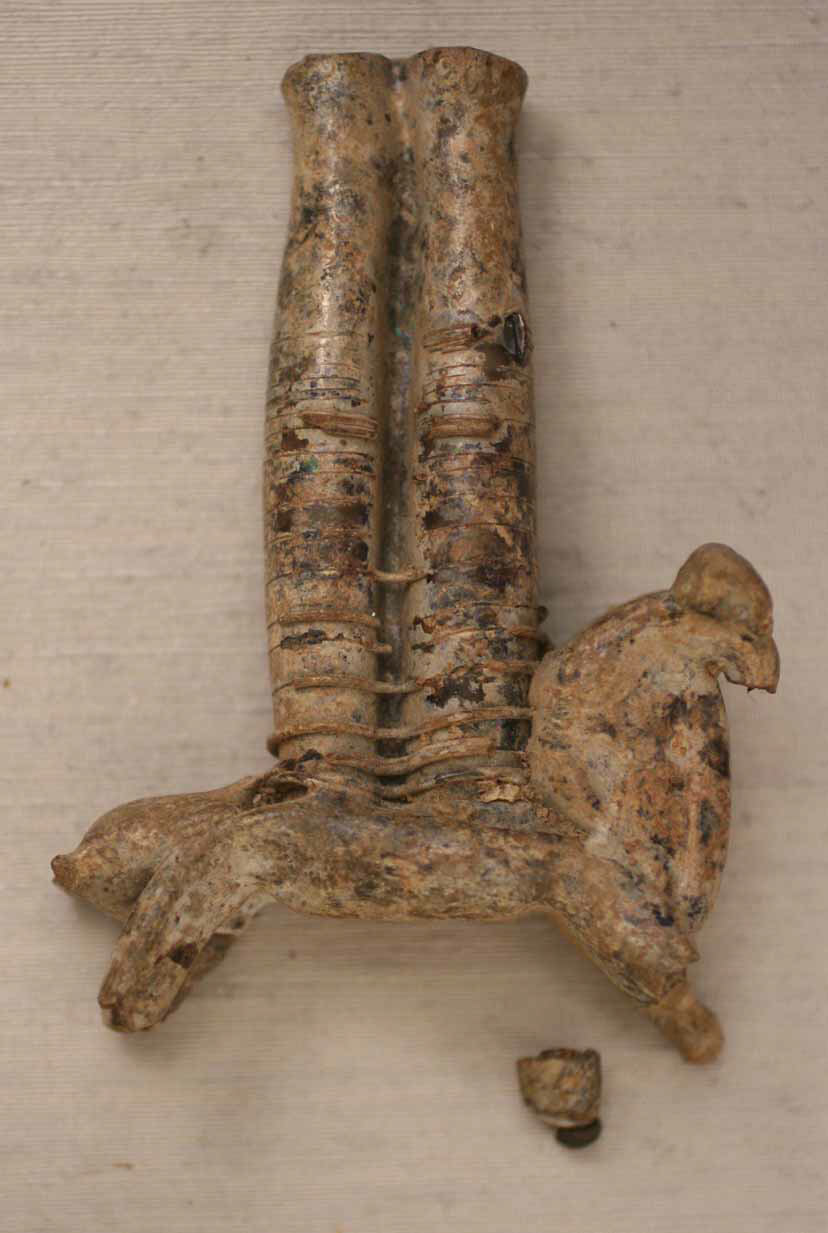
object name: kohl flask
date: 601-700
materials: glass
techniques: glassblowing, tooling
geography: syria